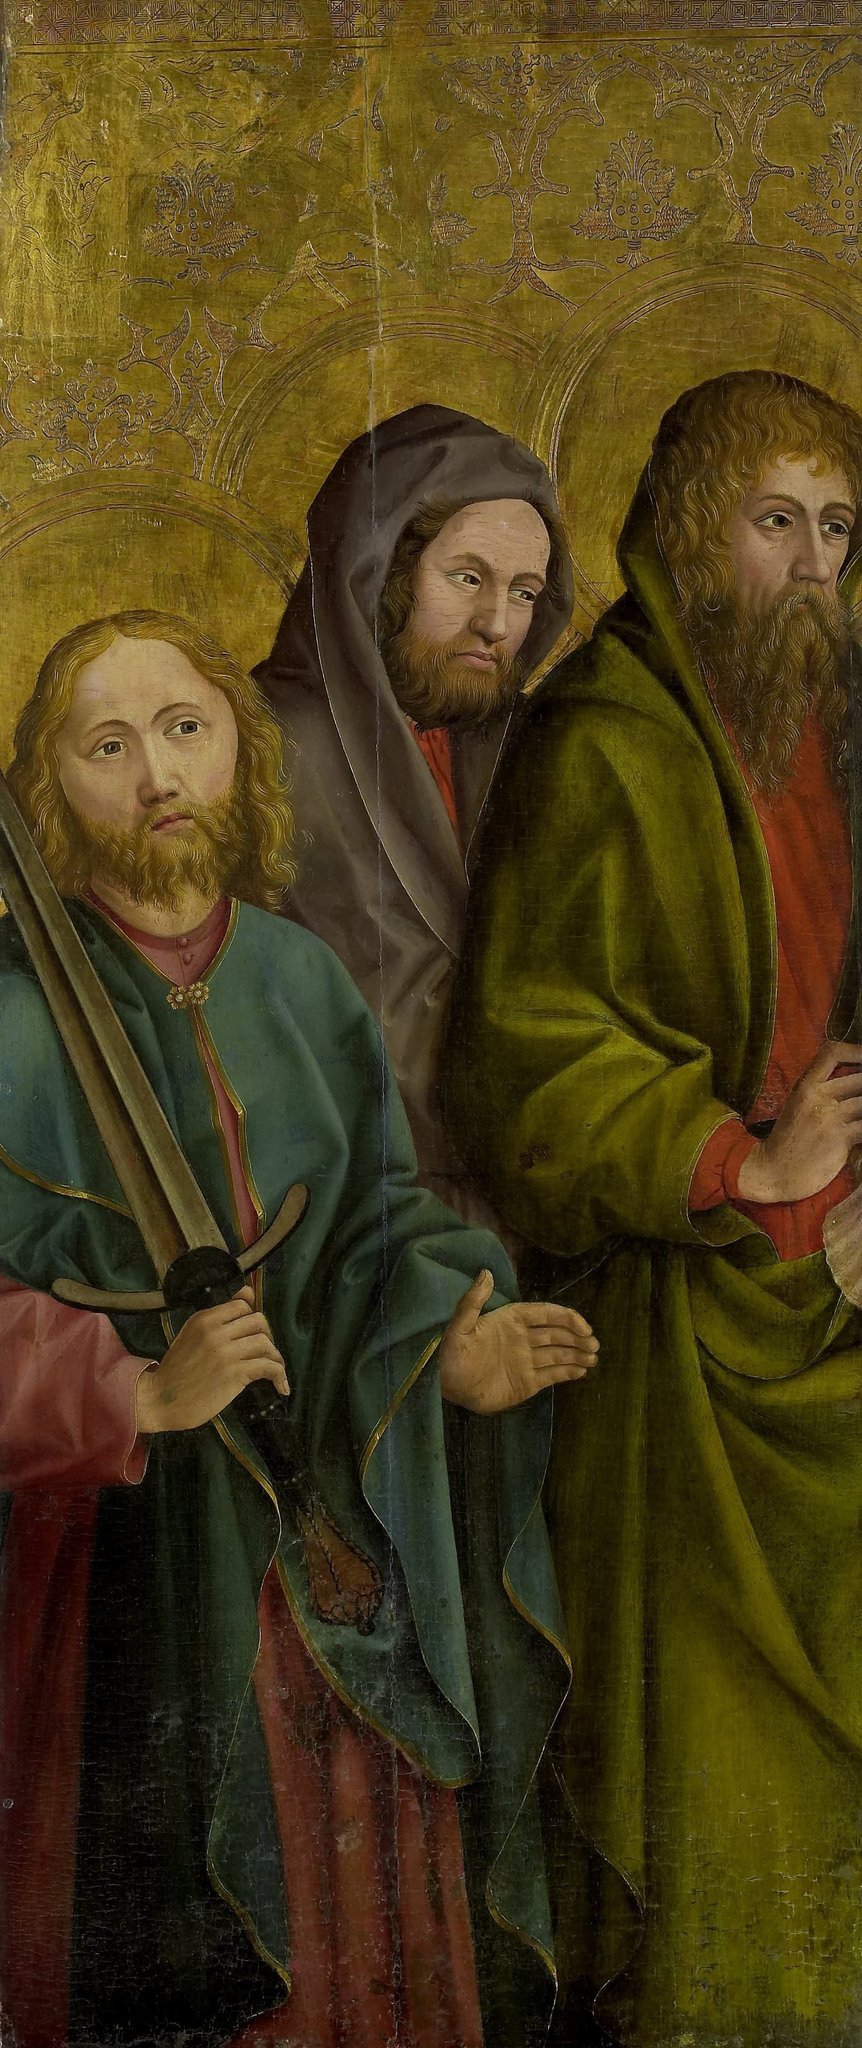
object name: painting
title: Three Apostles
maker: Anonymous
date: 1500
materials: oil, panel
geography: north germany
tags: (single) apostle, unspecified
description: Drie apostelen, staande, gezien tot de knieën. De man links heeft een zwaard in de rechterhand. Waarschijnlijk een fragment van een groter geheel.